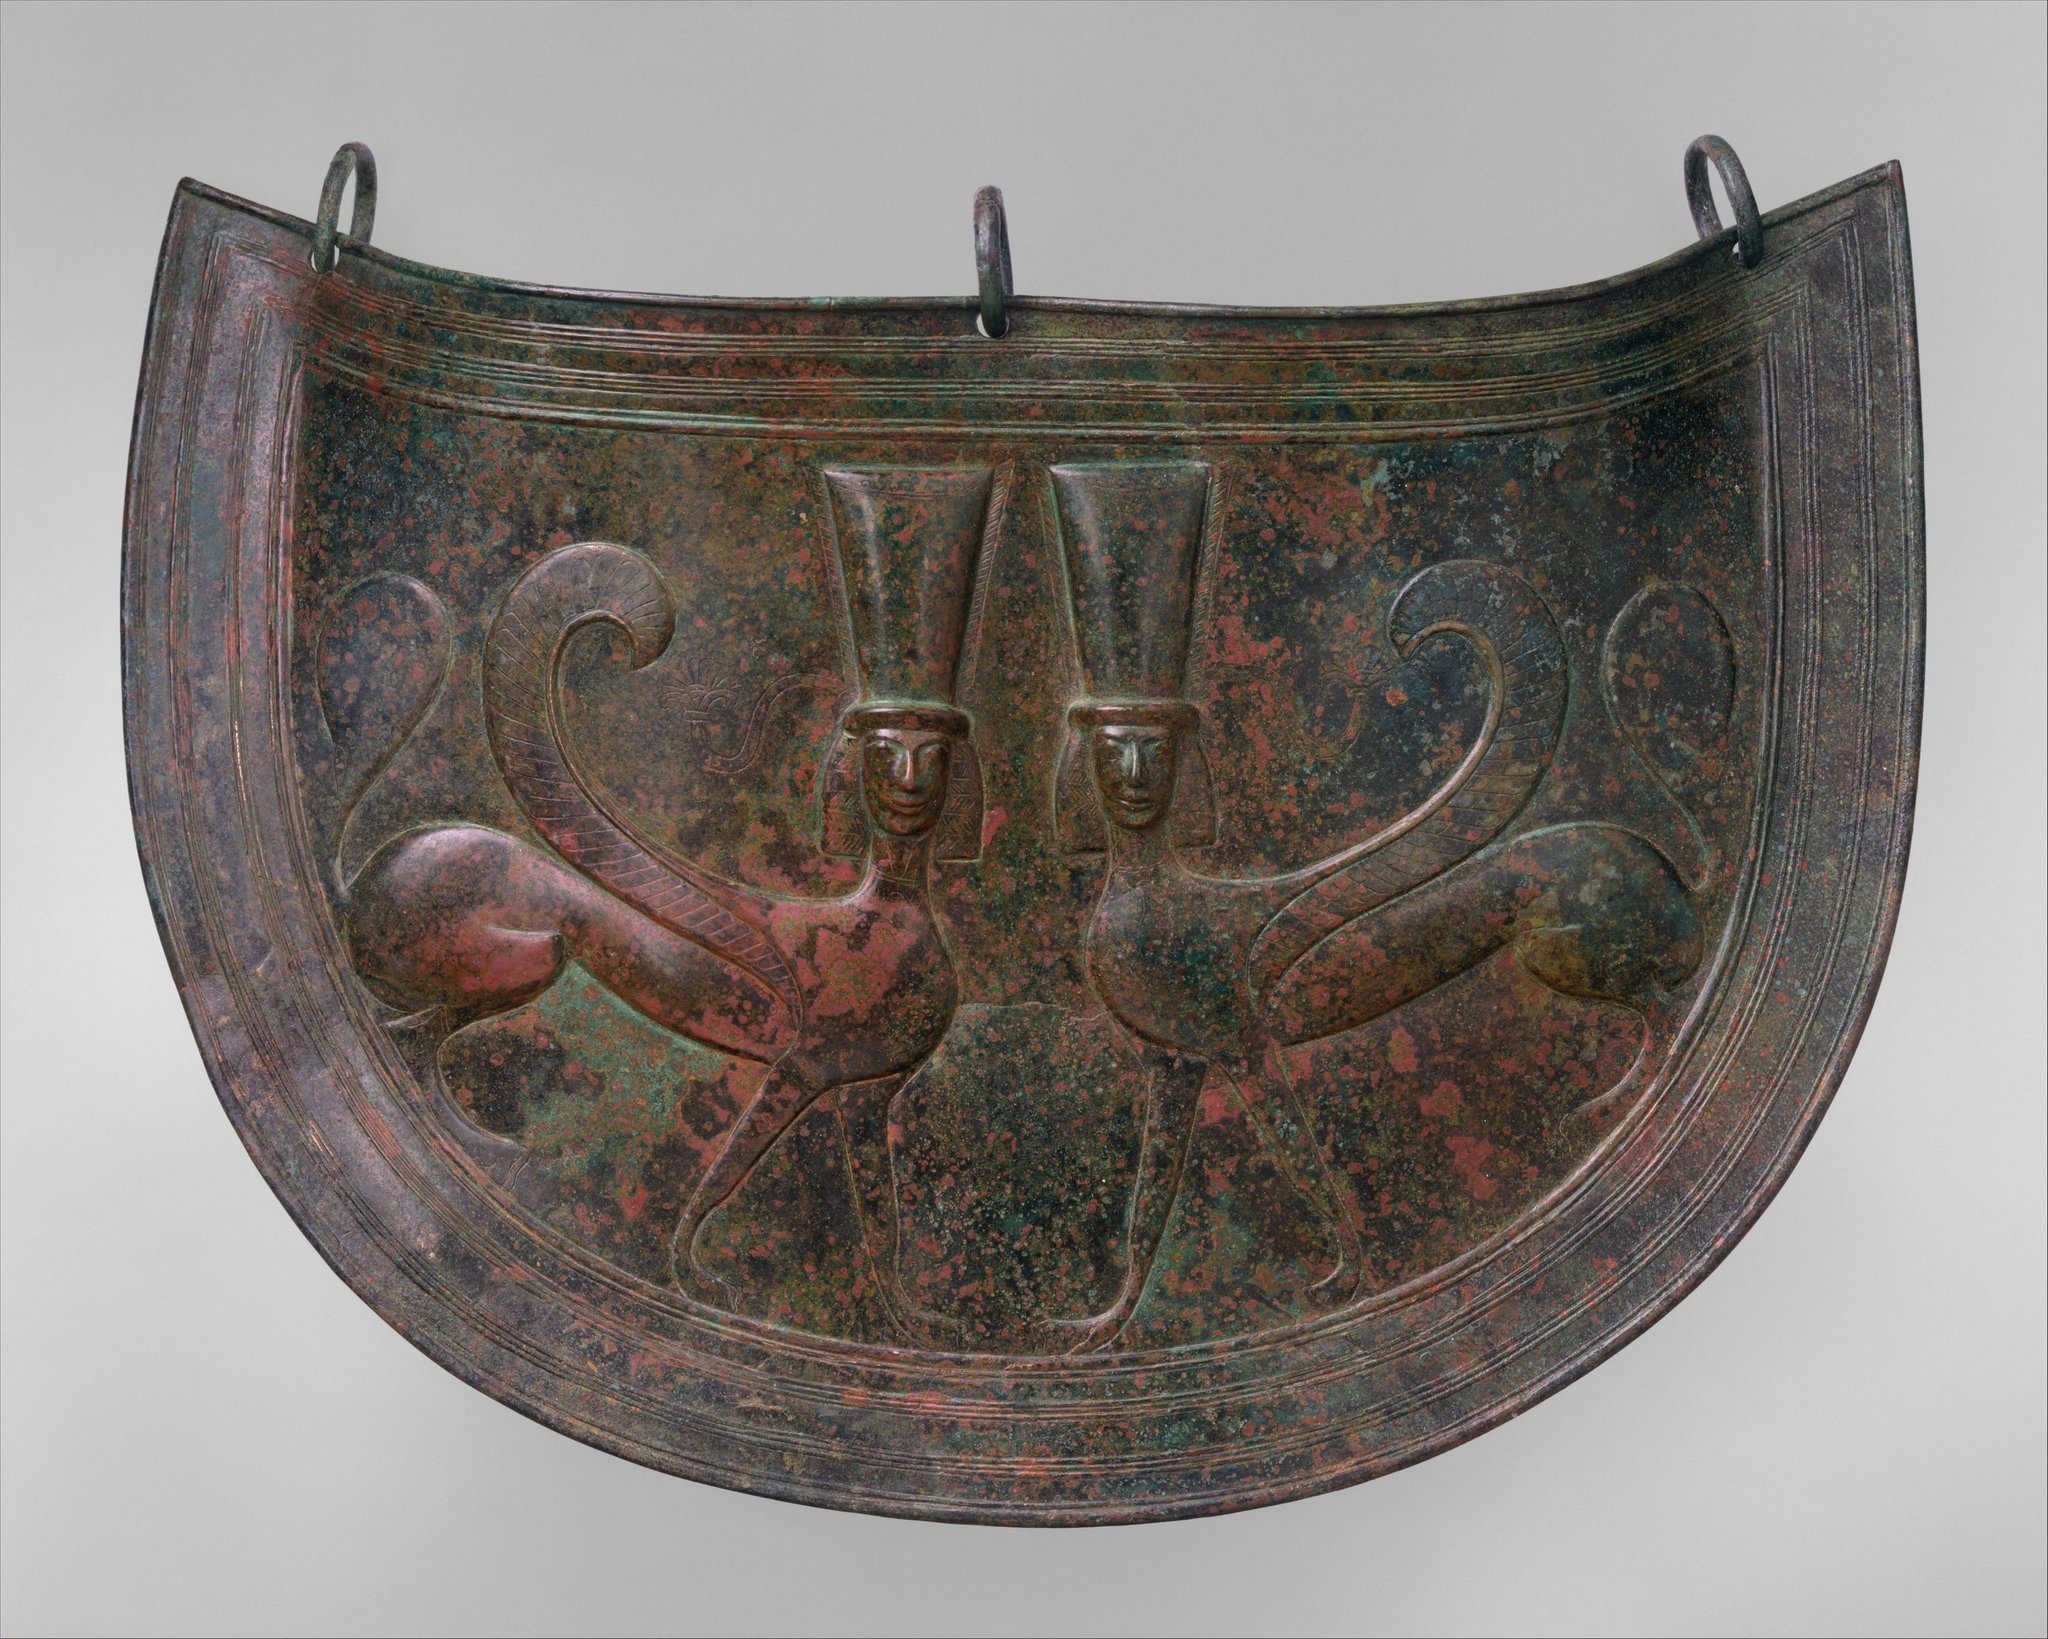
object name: mitra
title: Bronze mitra (belly guard)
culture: greek, cretan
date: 634-601 BCE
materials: bronze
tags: sphinx